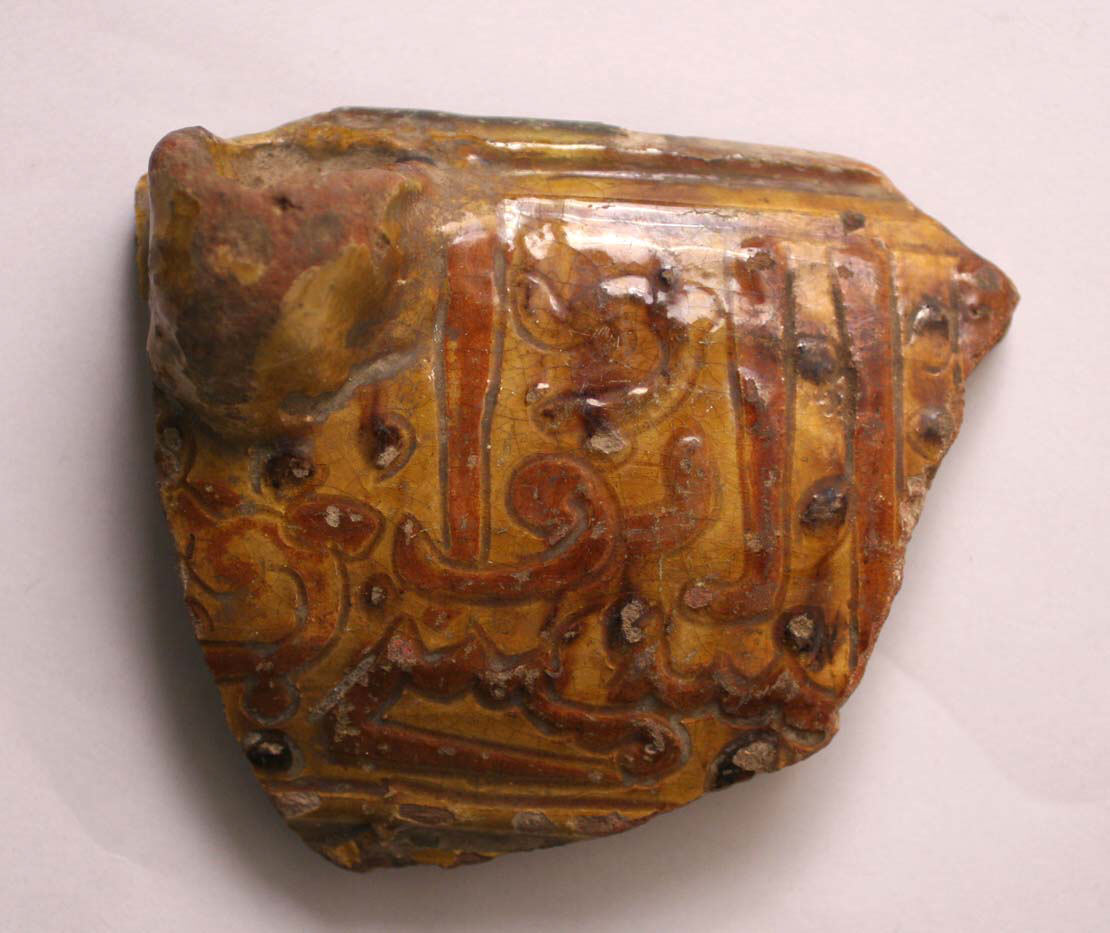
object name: fragment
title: Ceramic Fragment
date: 1301-1500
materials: earthenware, glaze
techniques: coloring, incising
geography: egypt